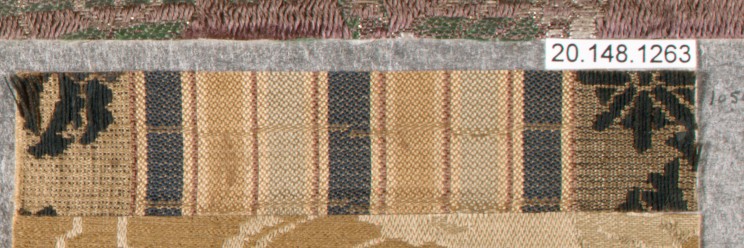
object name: piece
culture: japanese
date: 1701-1800